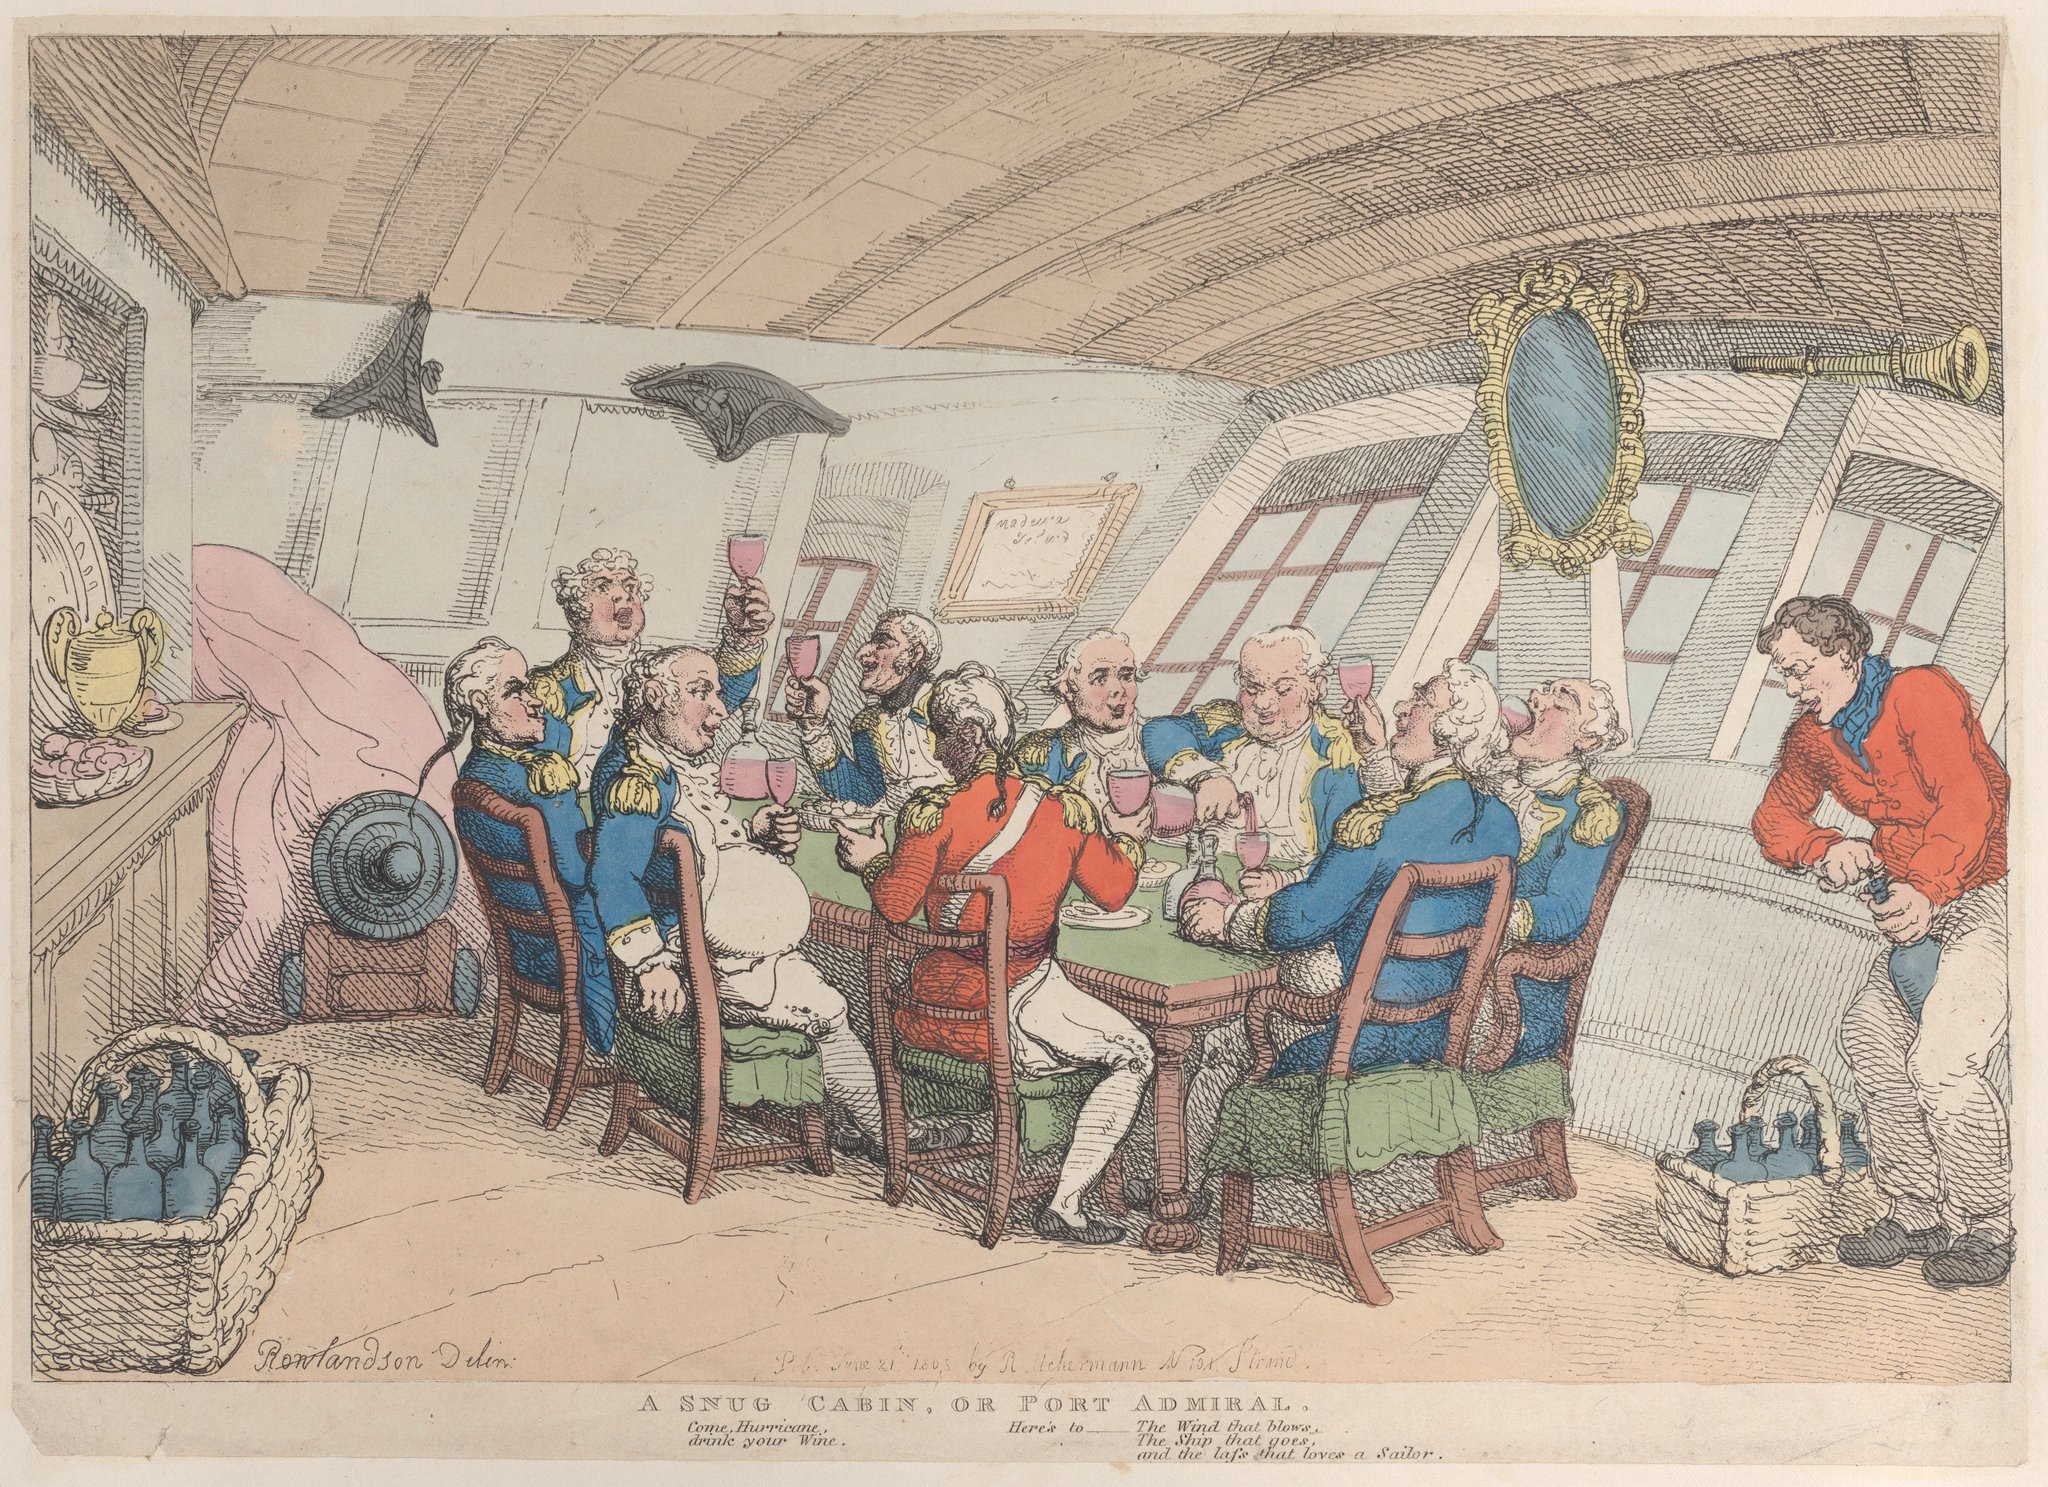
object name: print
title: A Snug Cabin, or Port Admiral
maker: thomas rowlandson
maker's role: artist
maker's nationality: british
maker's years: 1757-1827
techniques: etching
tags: satire,drinking,sailors,ships